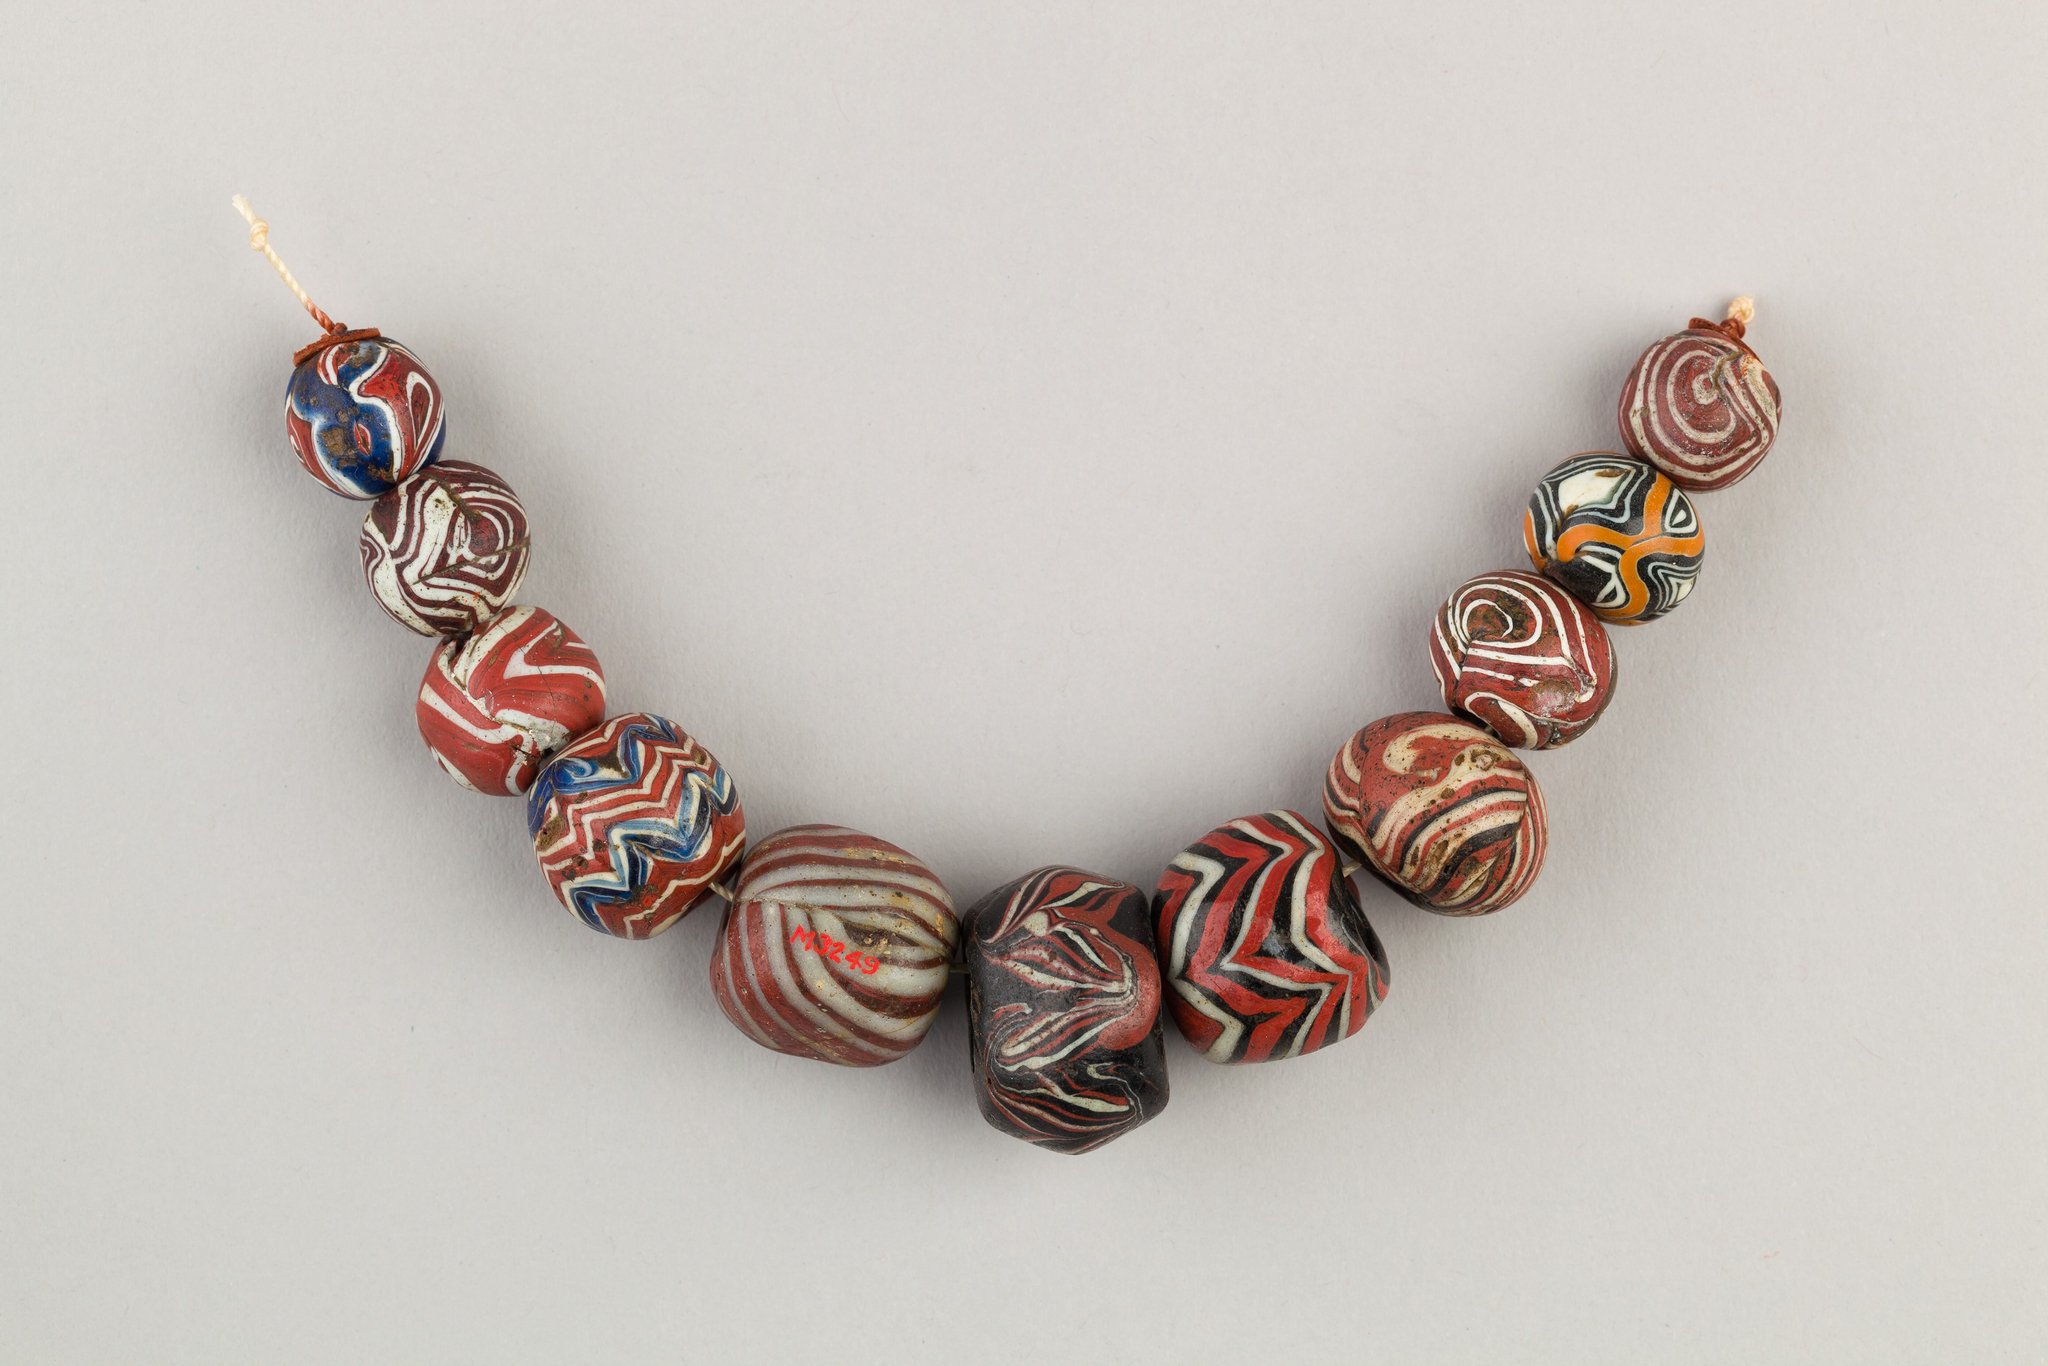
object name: bead, string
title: String of 11 beads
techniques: mosaic glass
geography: egypt